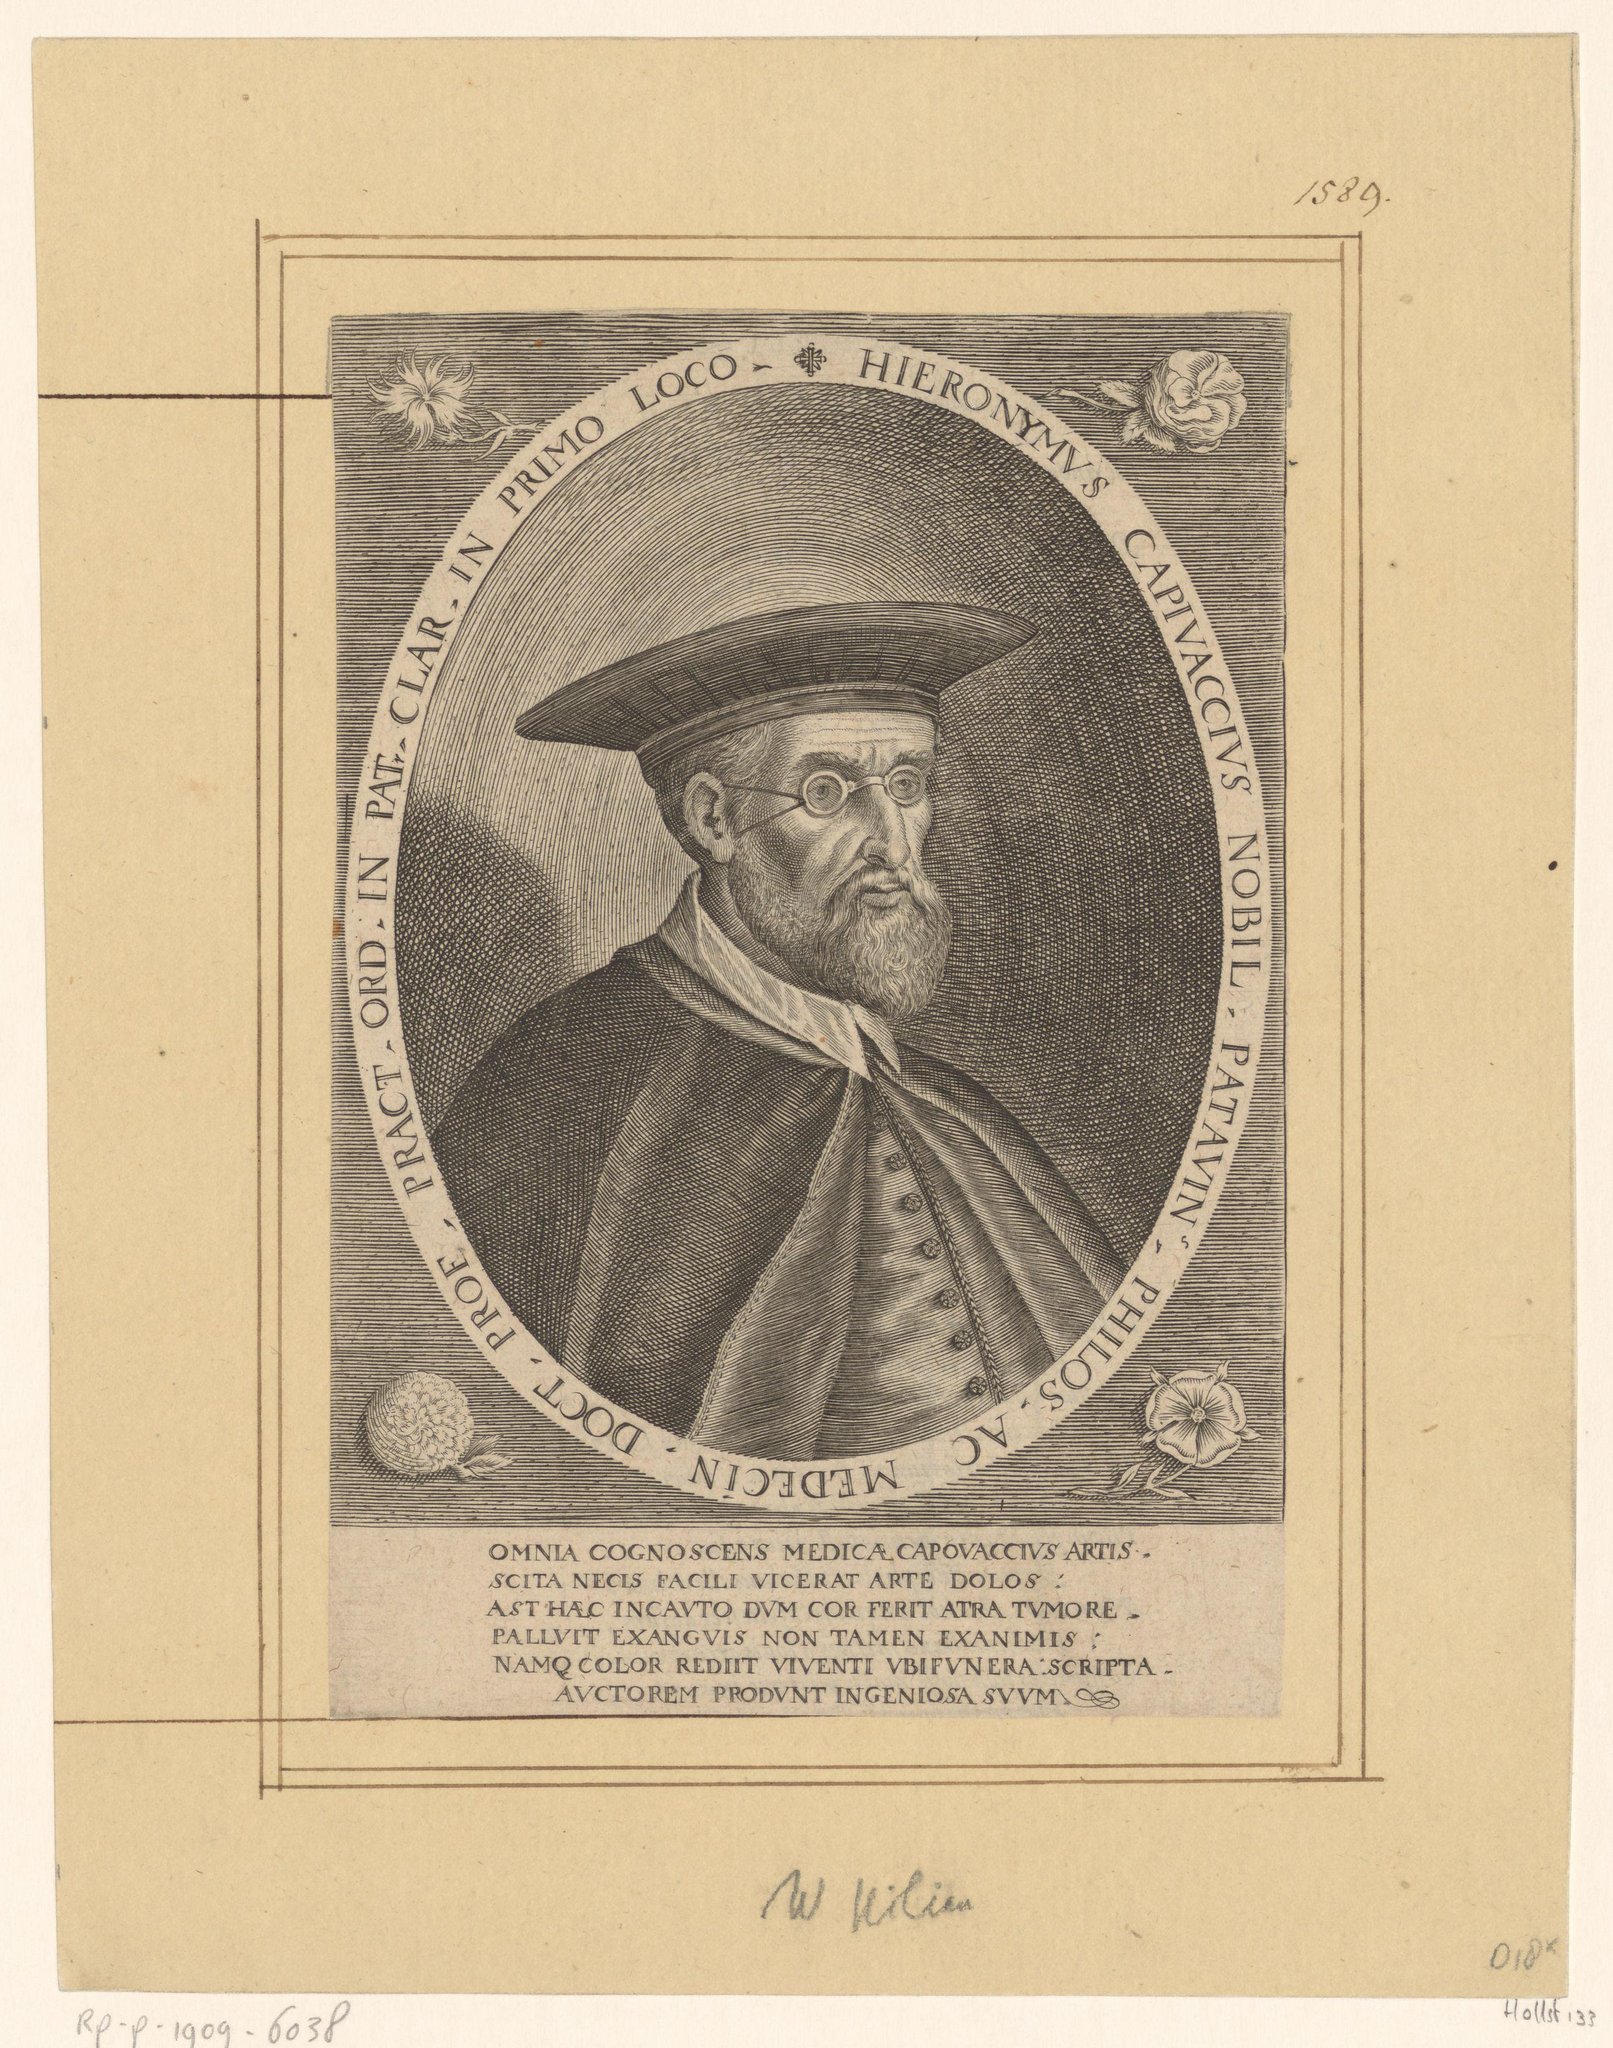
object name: print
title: Portret van Giralomo Capivaccio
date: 1591-1662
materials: paper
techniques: engraving, letterpress printing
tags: historical persons, physician, doctor (+ portrait of scholar, scientist)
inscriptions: collector's mark: Lugt 2228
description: Tekst in het Latijn in de omlijsting en in de ondermarge.